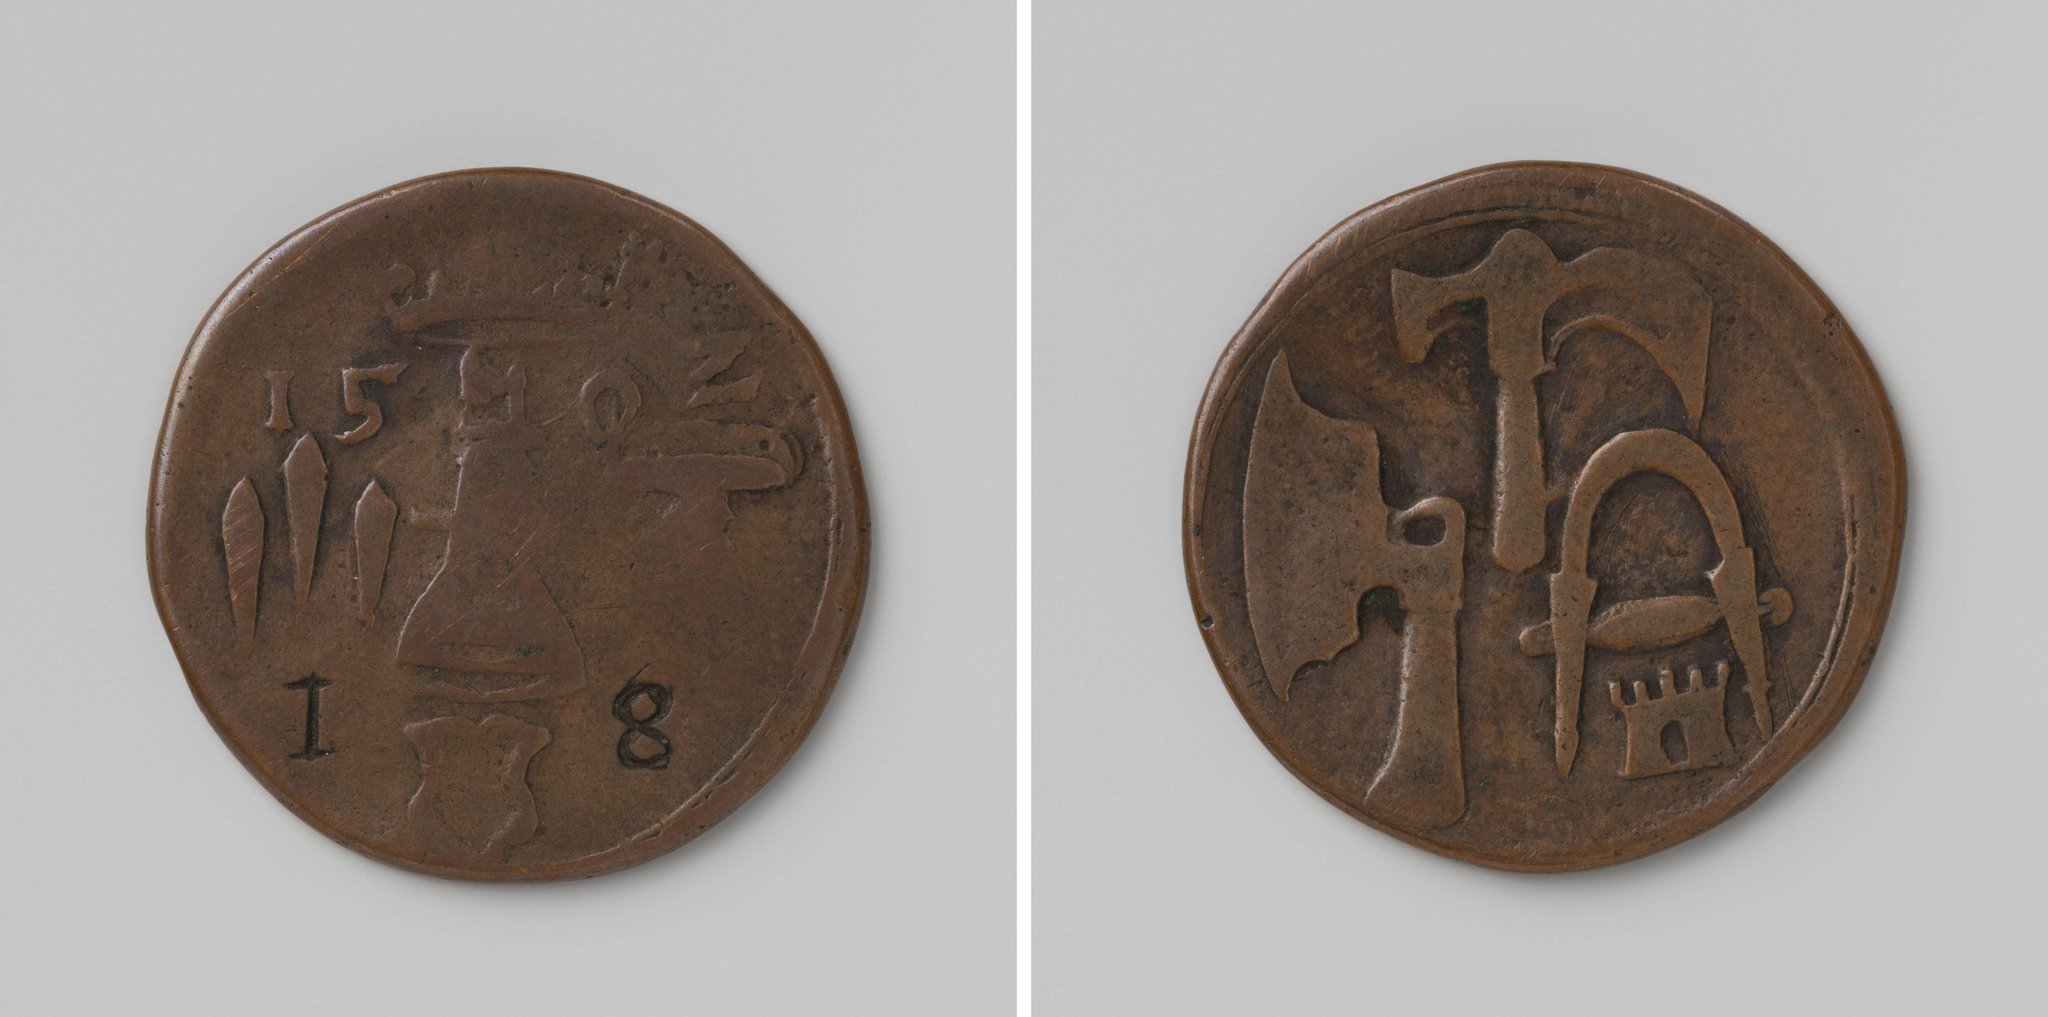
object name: medal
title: Kuipersgilde van Middelburg, gildepenning met no. 18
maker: Anonymous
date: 1592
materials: copper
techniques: engraving, striking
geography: middelburg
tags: middelburg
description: Koperen penning. Voorzijde: gekroond kuipersaambeeeld tussen jaartal, geflankeerd door drie aandrijvers en een boor boven schild tussen cijfers 1 en 8. Keerzijde: bijl, kuipershamer en kuiperspasser; tussen benen van passer: burcht